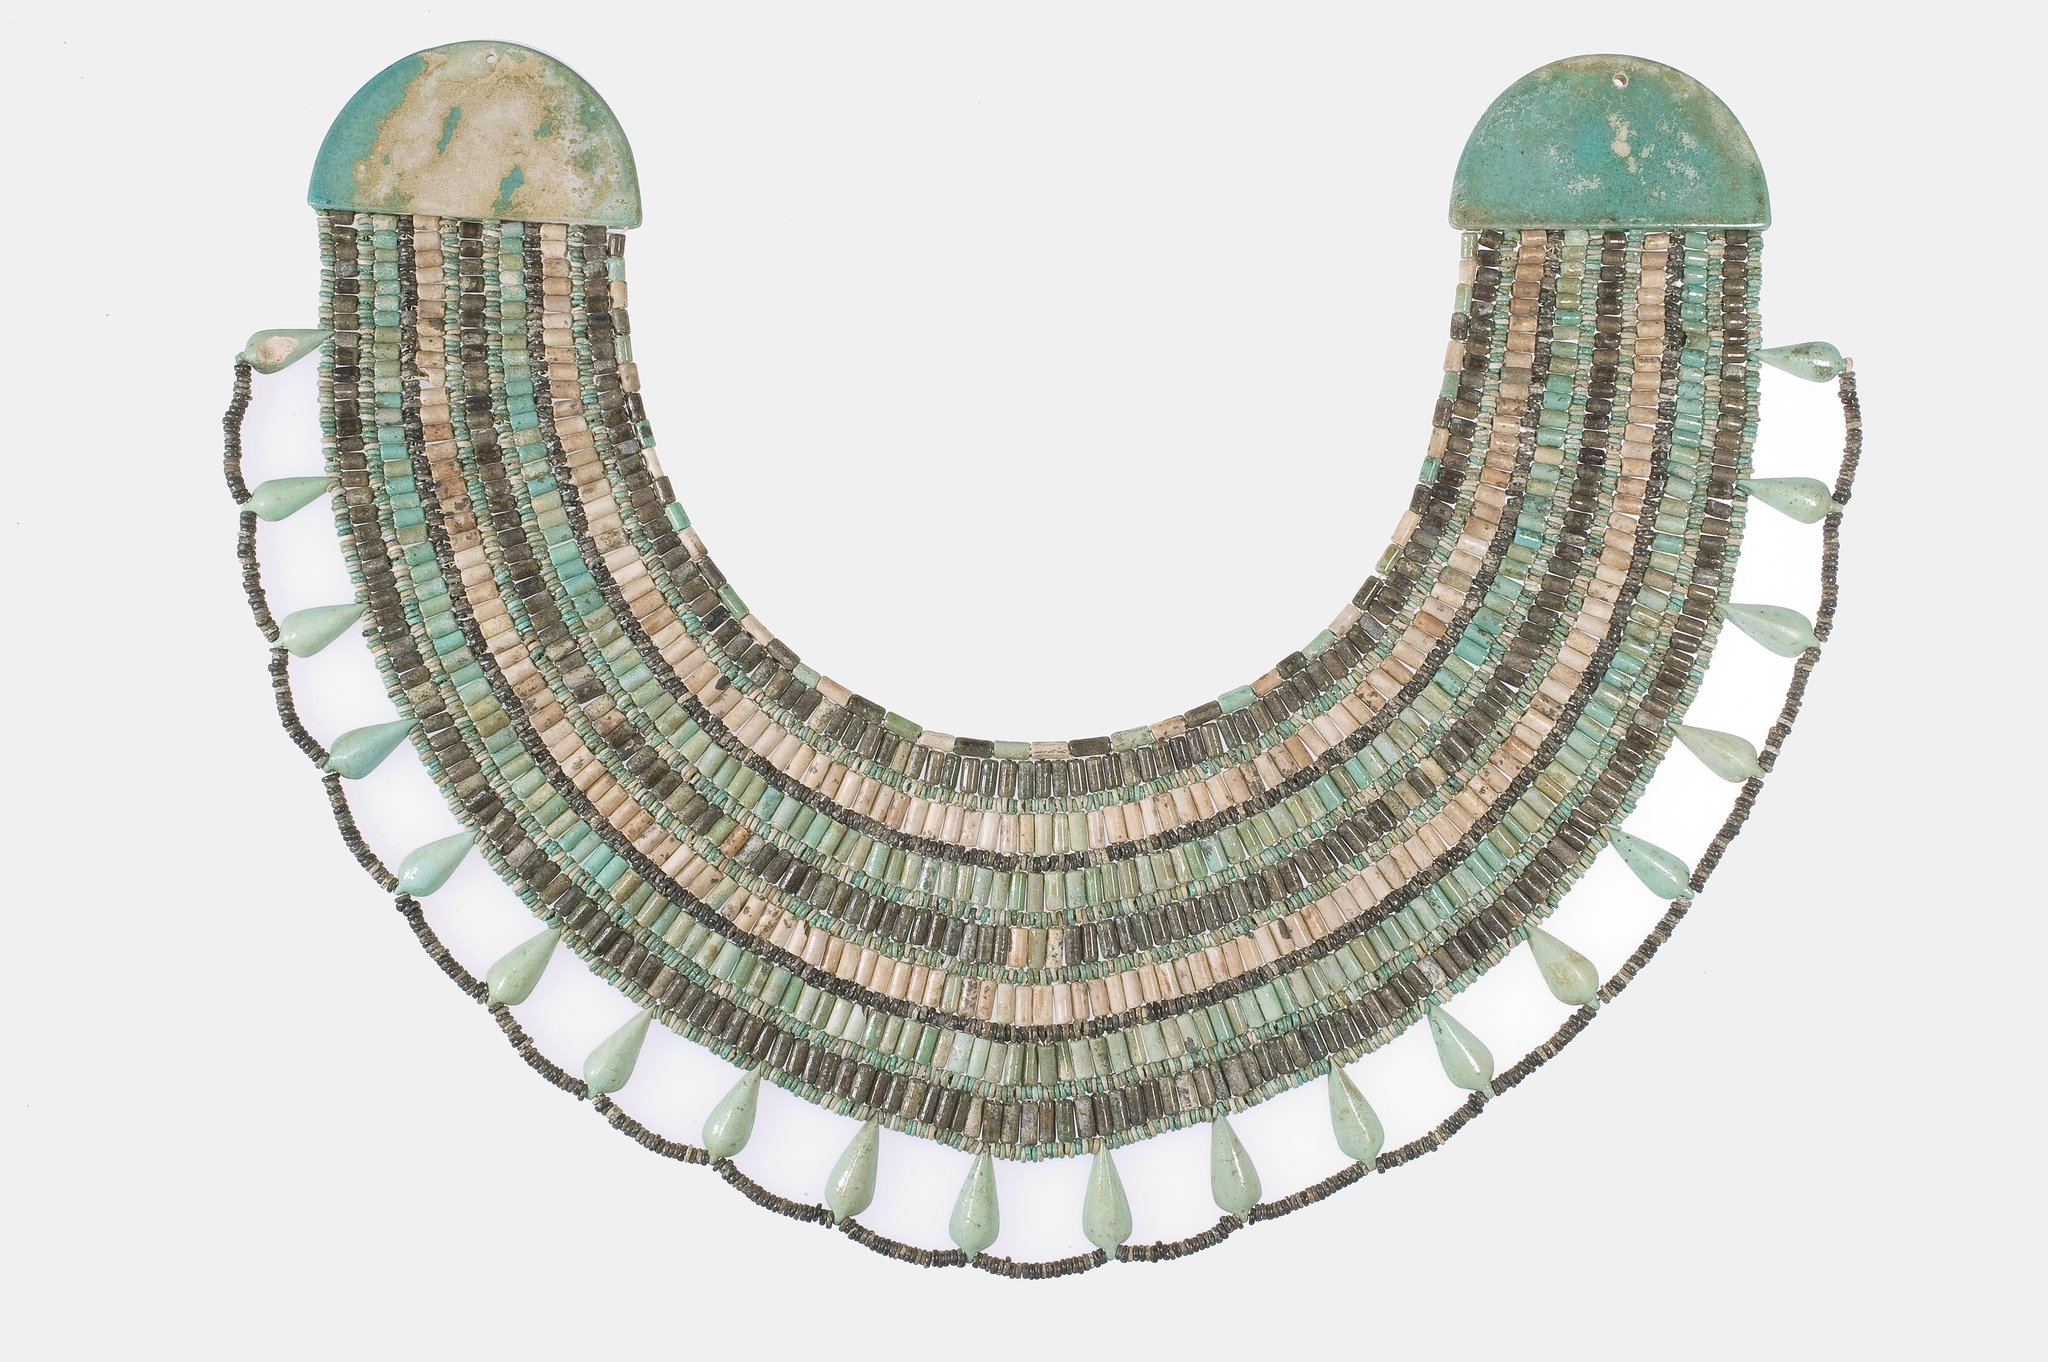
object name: broad collar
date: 1981-1640 BCE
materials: faience, paste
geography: egypt